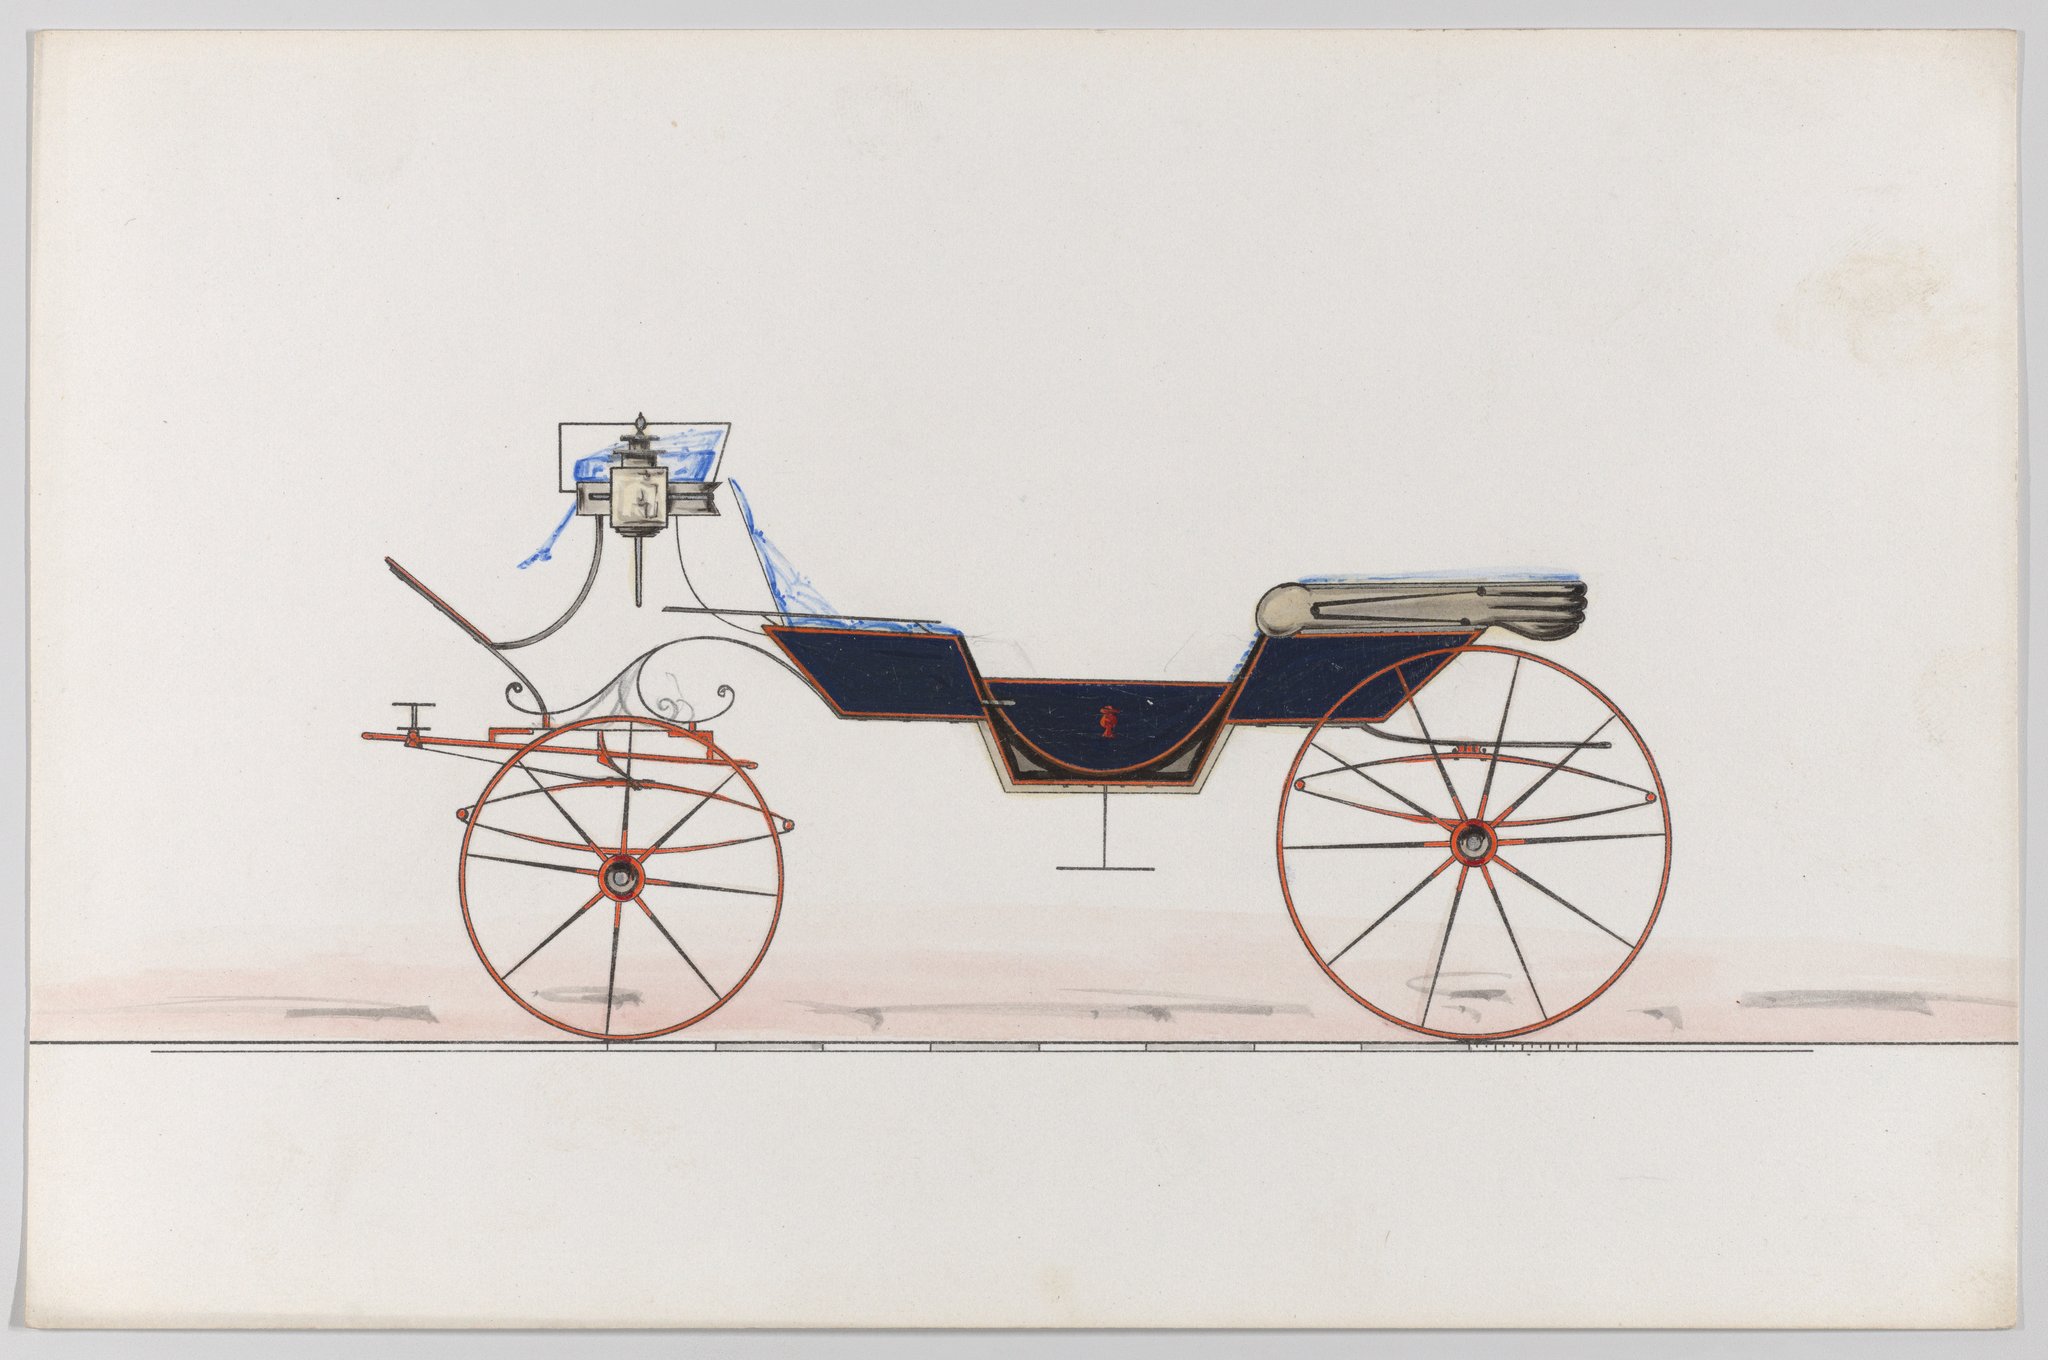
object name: drawing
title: Design for Vis-à-vis (unnumbered)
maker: brewster & co.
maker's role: manufacturer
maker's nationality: american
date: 1875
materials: gouache, gum arabic, ink, watercolor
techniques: pen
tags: carriages